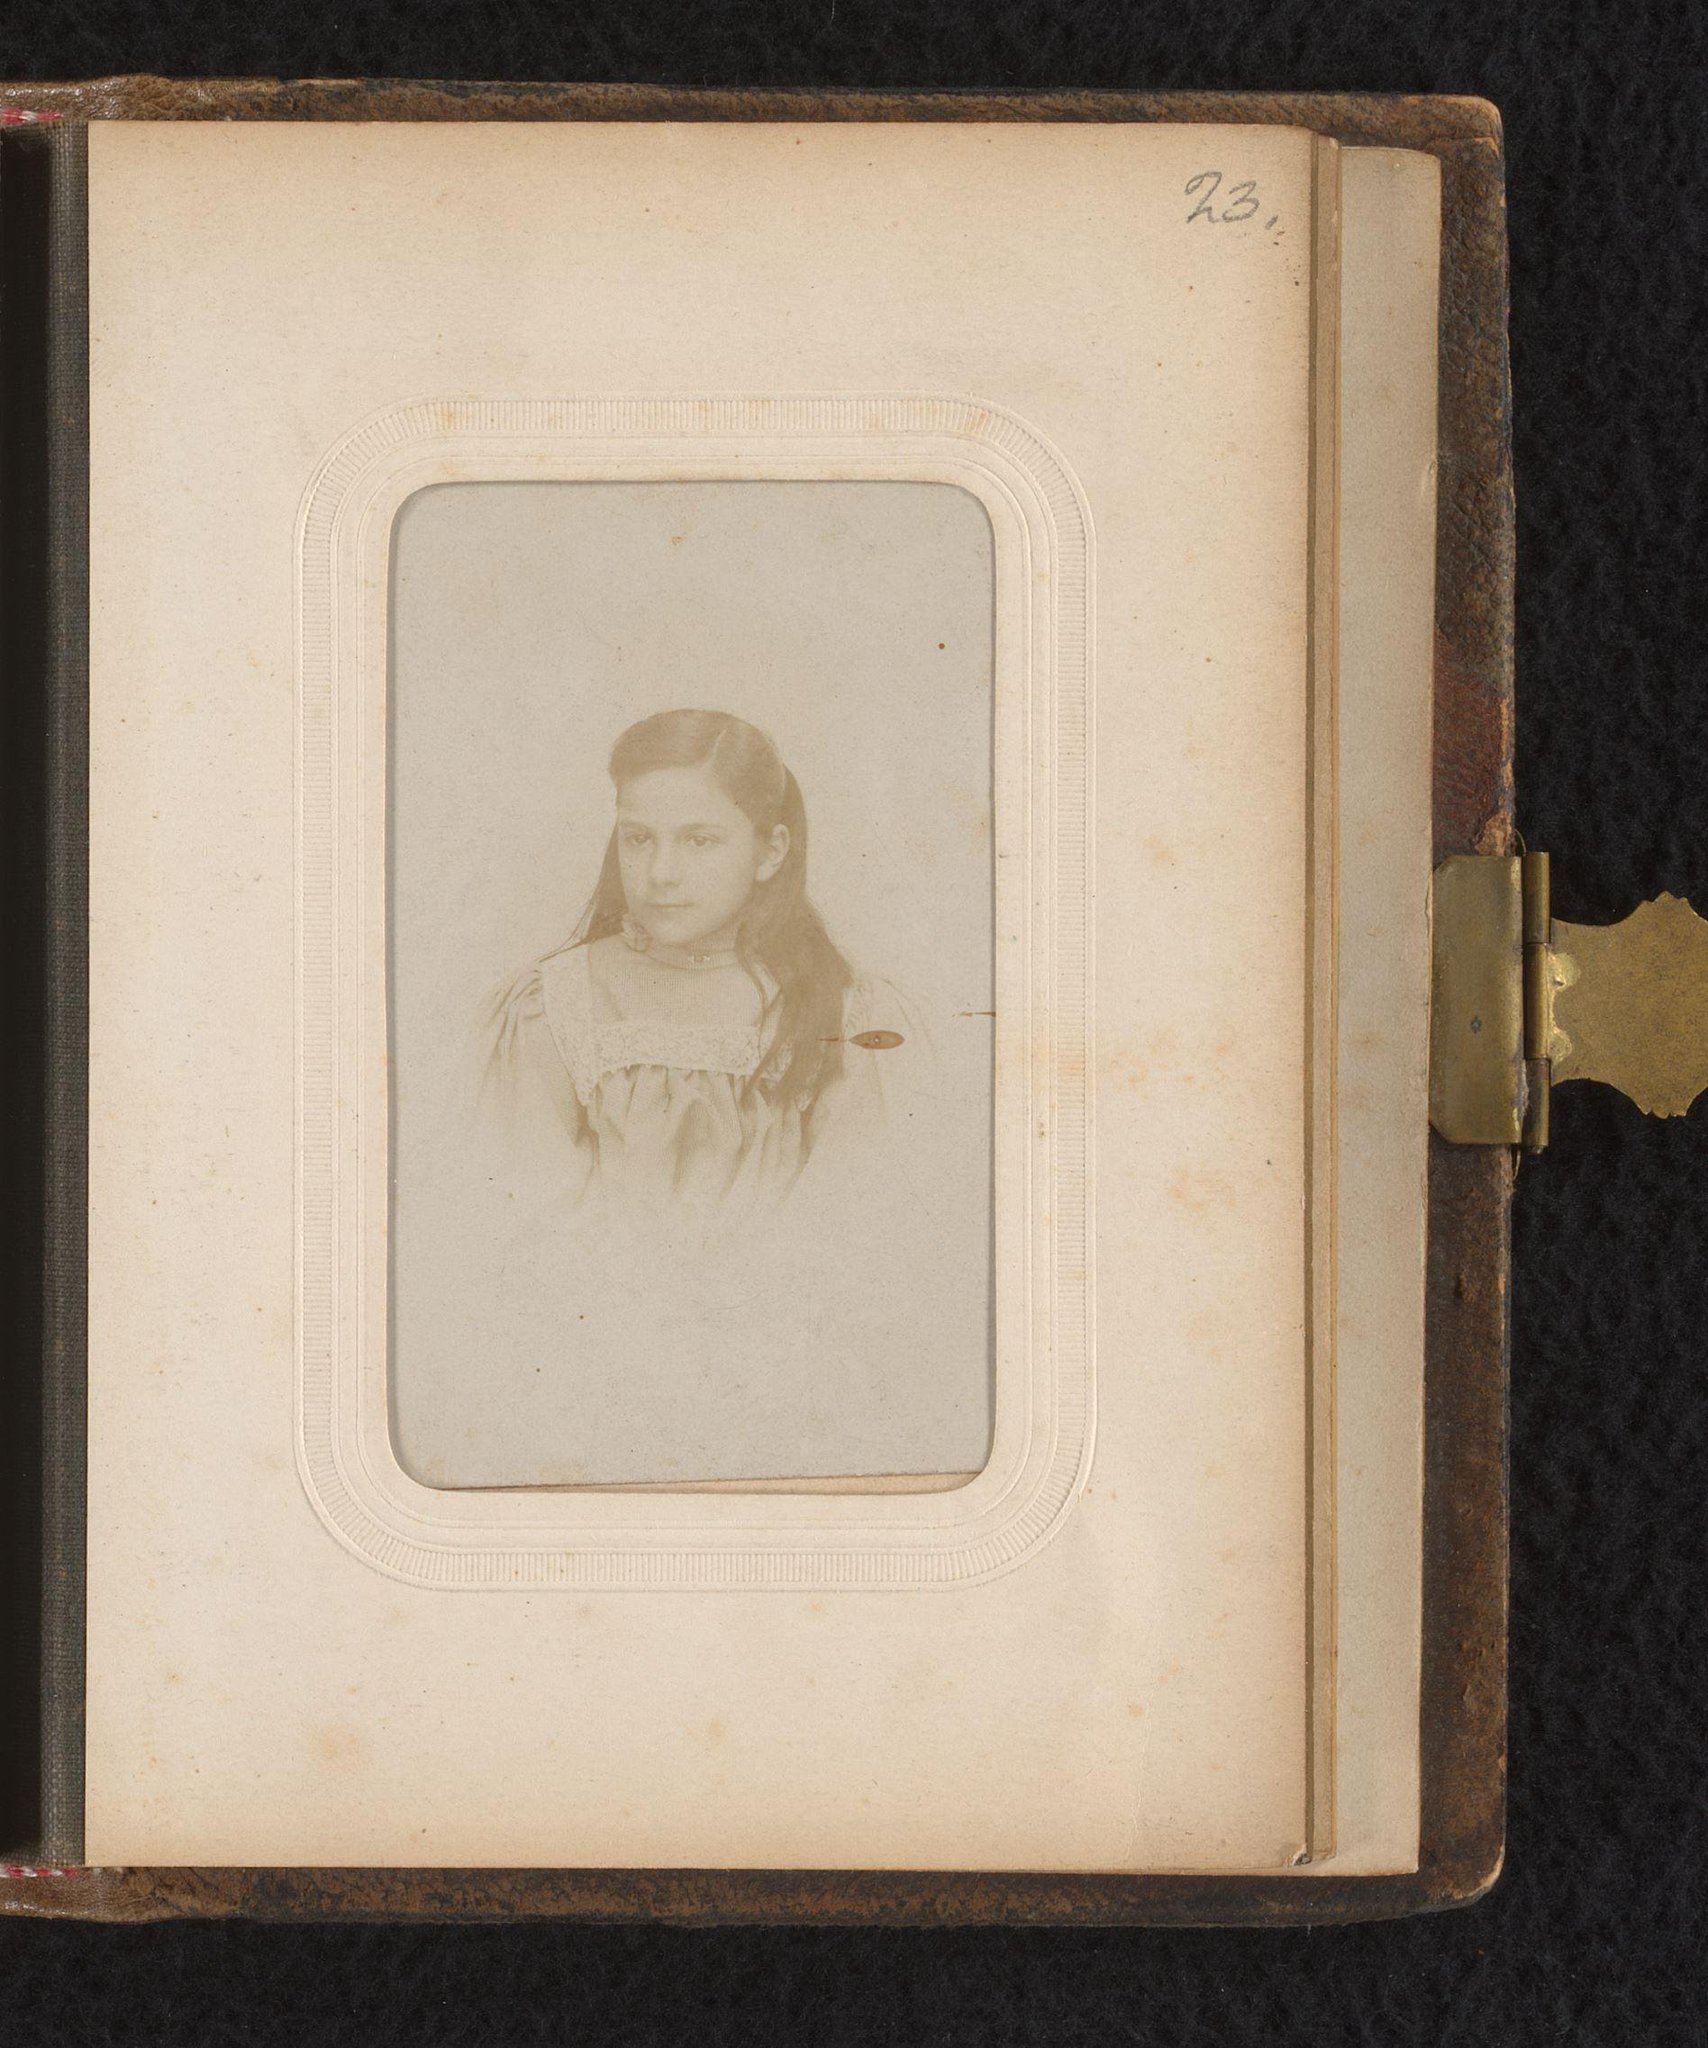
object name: carte de visite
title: Portret van Petronella Hermina Bon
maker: coenraad jacob snooij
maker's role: publisher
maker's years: 1874-1972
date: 1893-1900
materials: paper, cardboard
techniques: collodion silver print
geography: north holland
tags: amsterdam, historical persons - bb - woman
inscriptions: inscription: ‘Photographie C.J. Snooij’, inscription: ‘Petronella/ Hermina Bon’